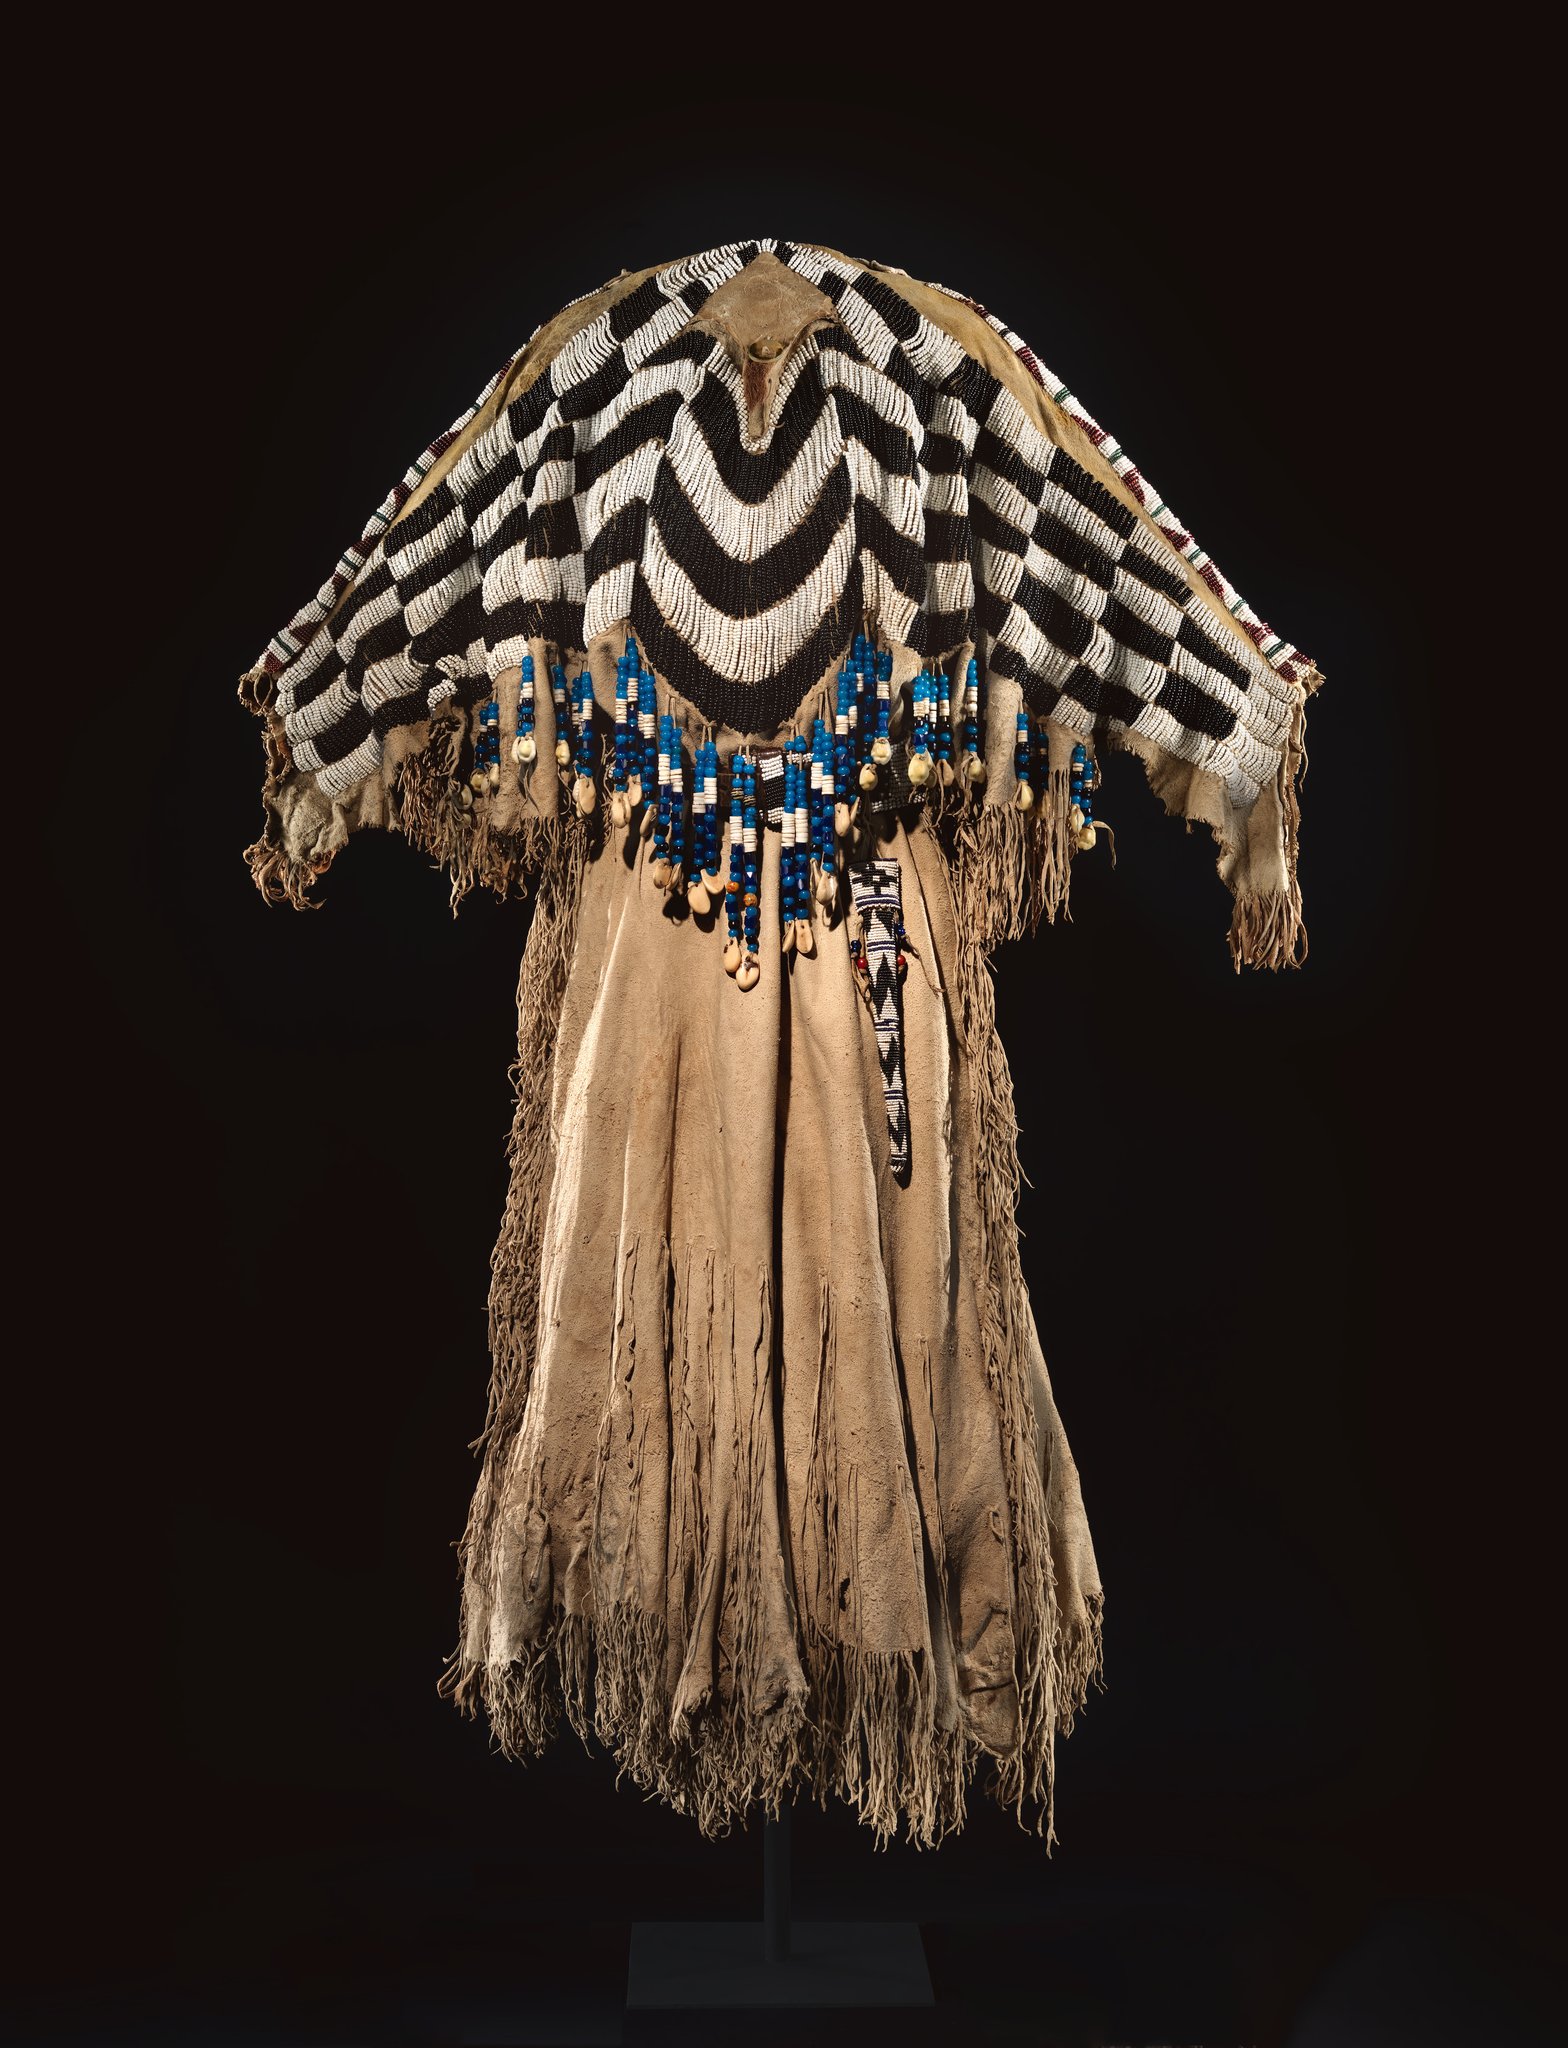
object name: dress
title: Dress and belt with awl case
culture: wasco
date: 1870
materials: bone, brass, glass, leather, metal, shell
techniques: tanning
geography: united states